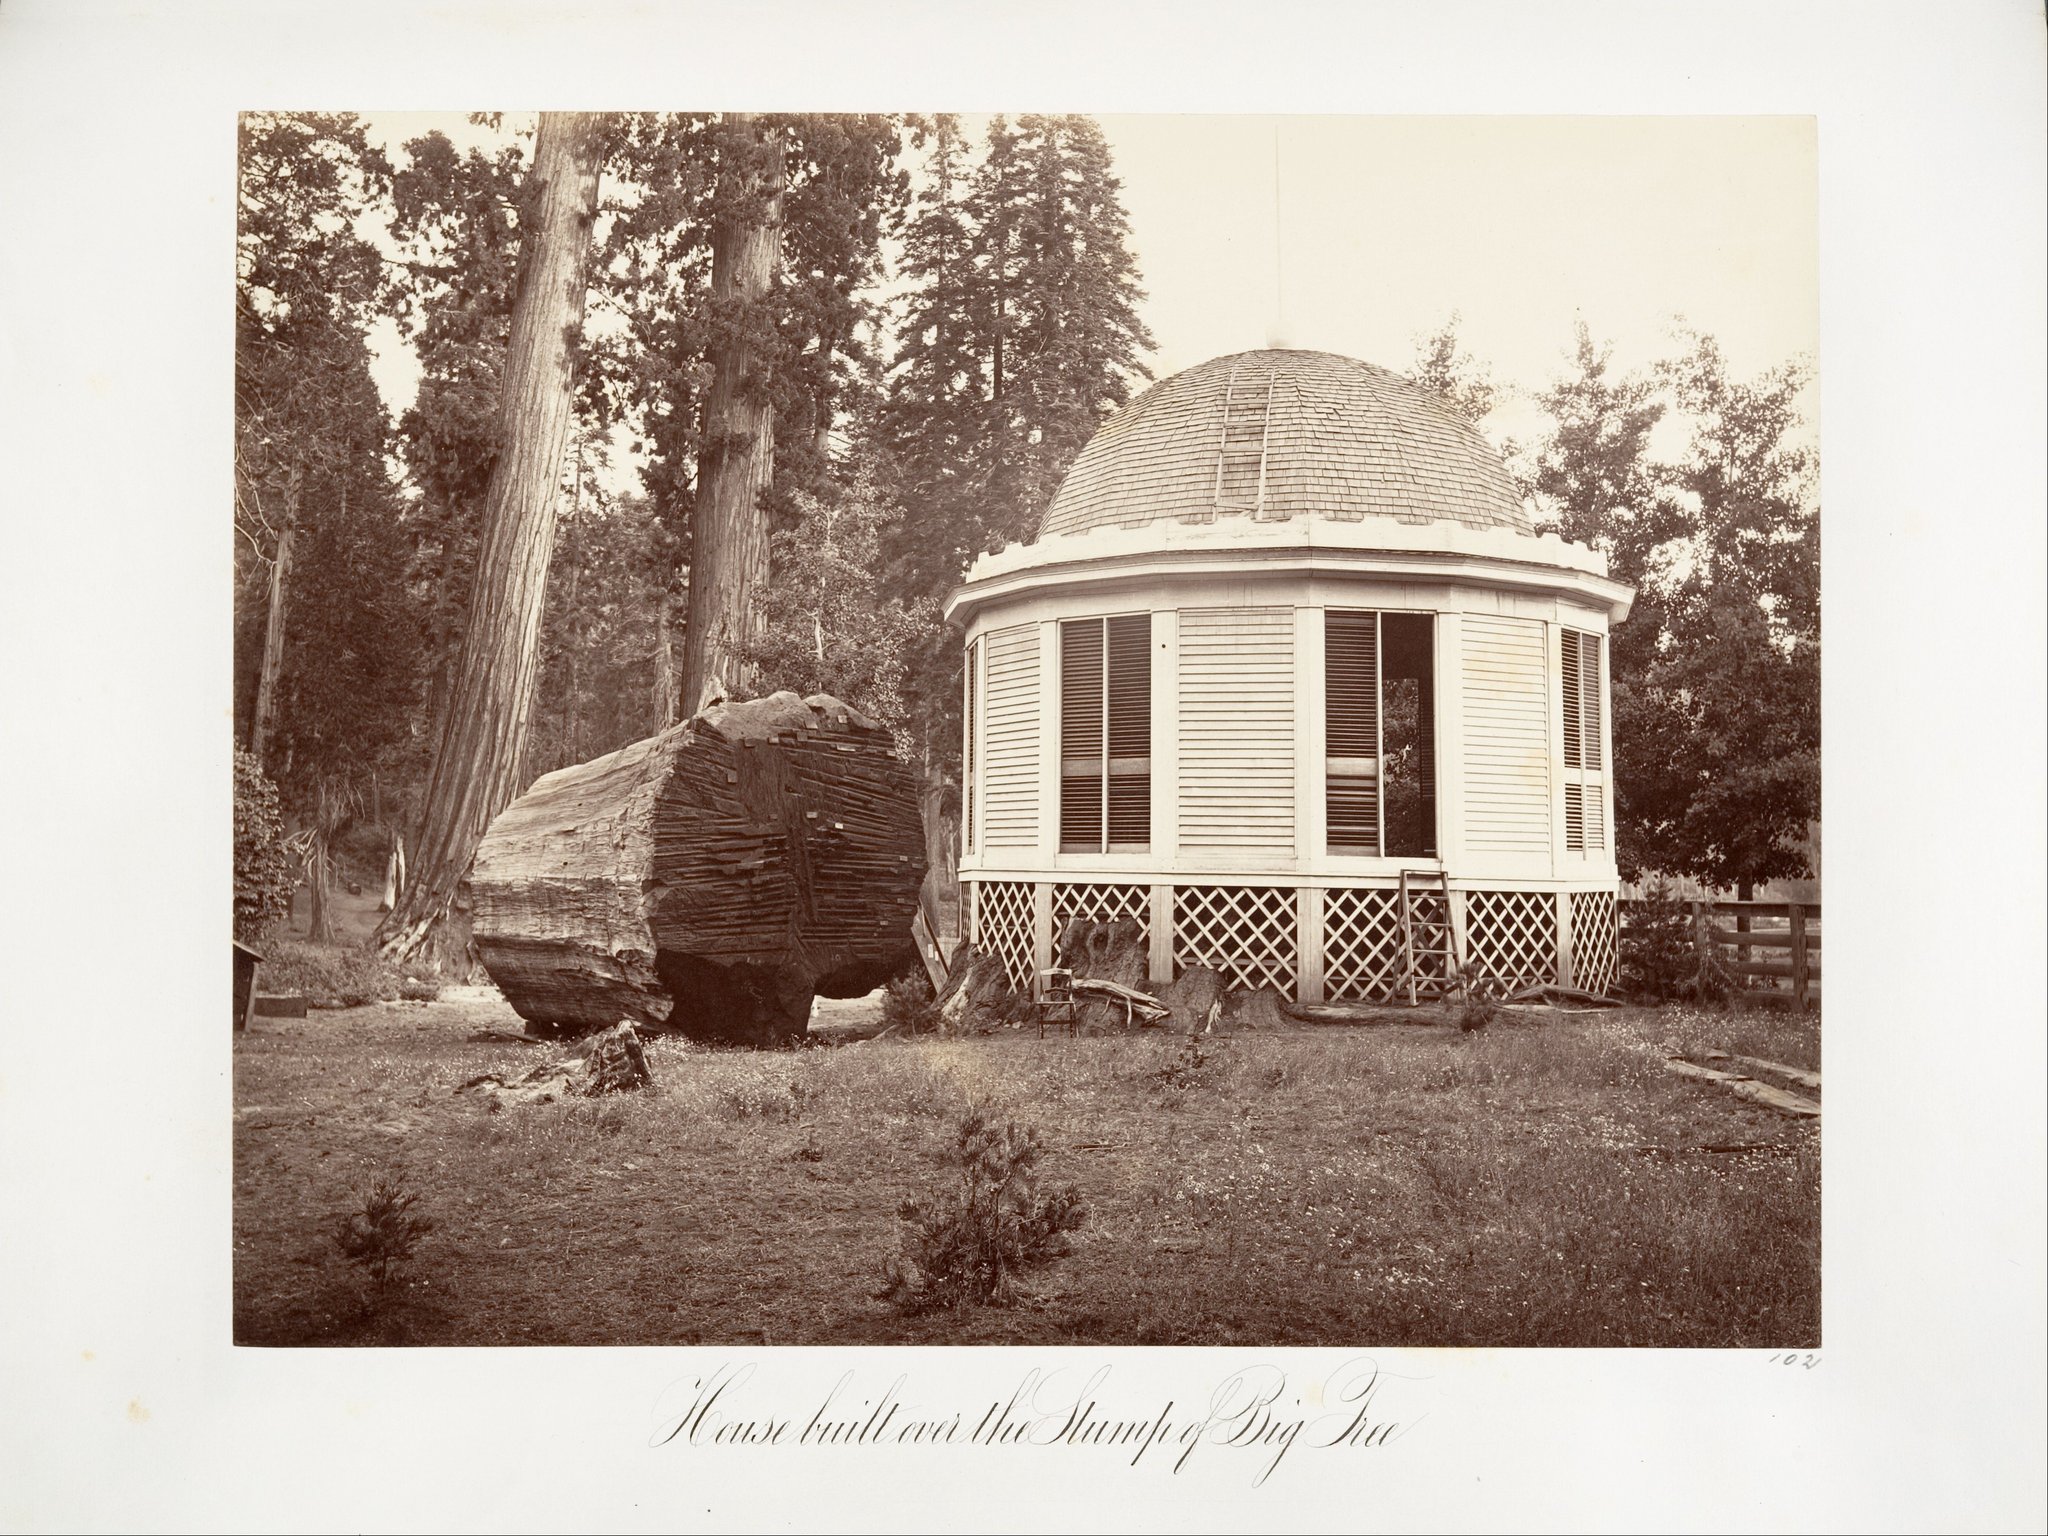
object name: photograph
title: The House Built over the Stump of a Big Tree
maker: carleton e. watkins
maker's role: artist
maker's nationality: american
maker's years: 1829-1916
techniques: albumen silver print, glass negative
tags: architecture,houses